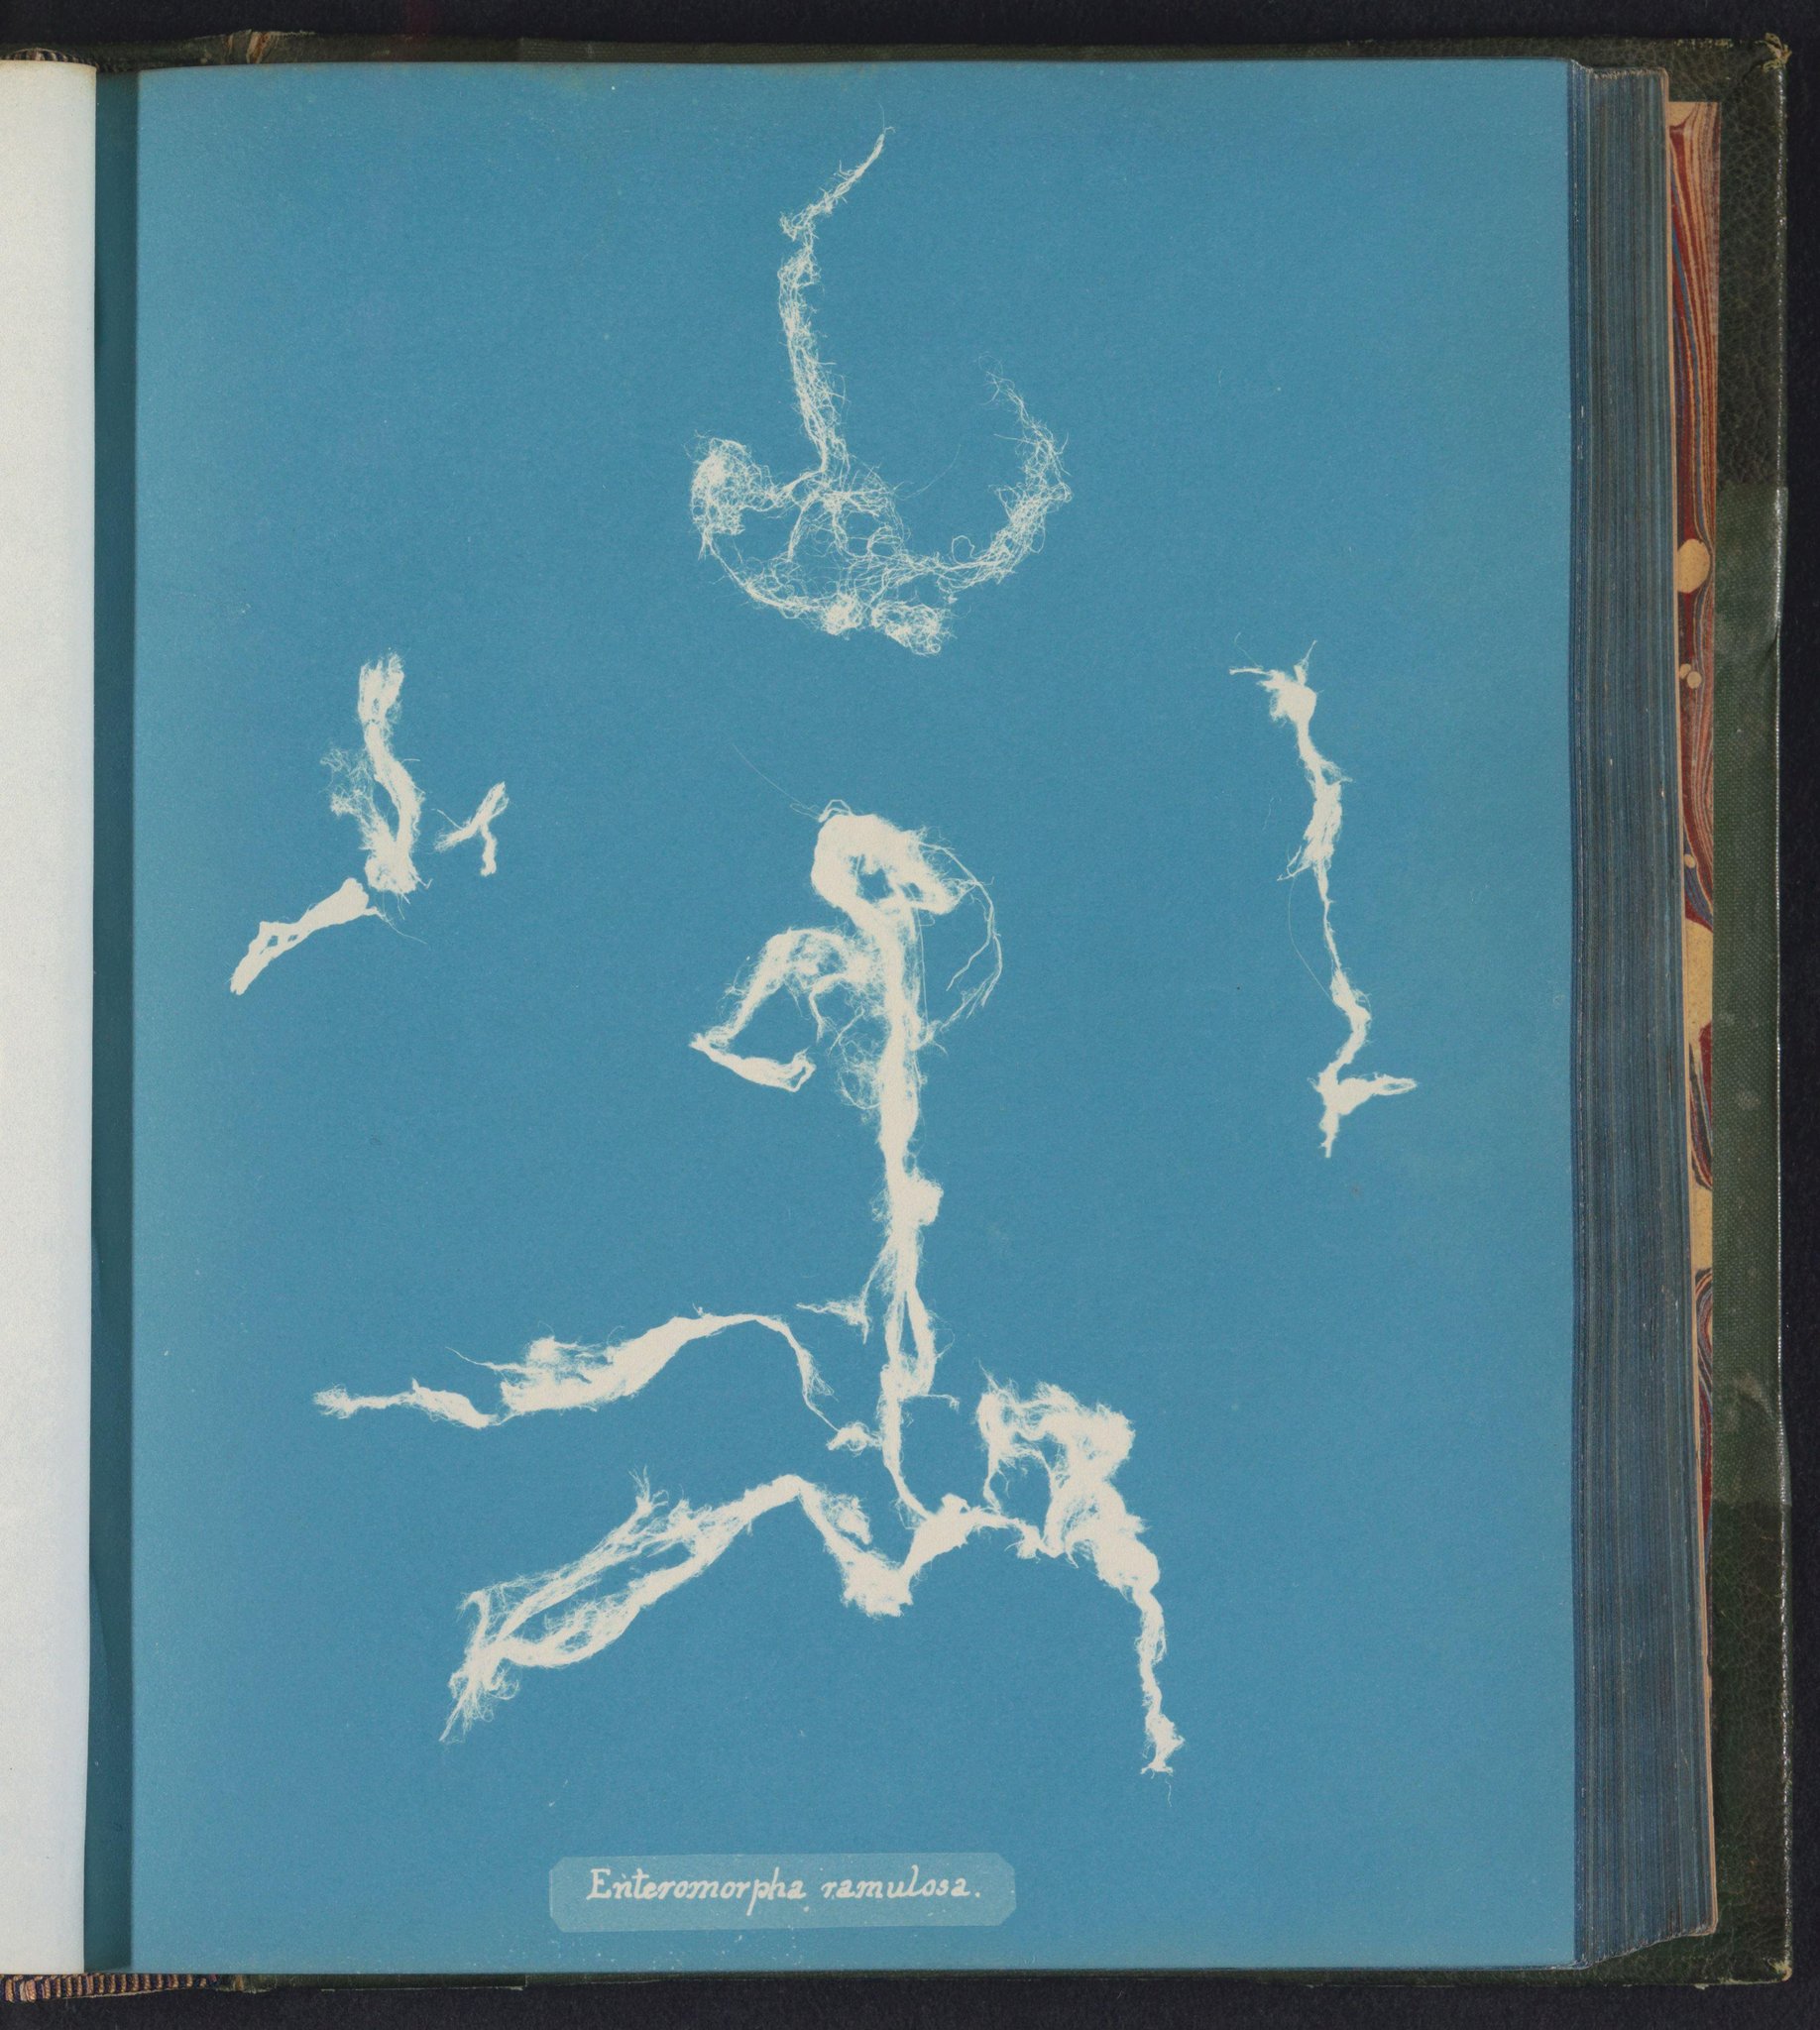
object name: page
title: Zeewier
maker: anna atkins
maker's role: fotograaf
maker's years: 1799-1871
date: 1843-1853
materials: photographic support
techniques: cyanotype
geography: united kingdom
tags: algae, seaweed